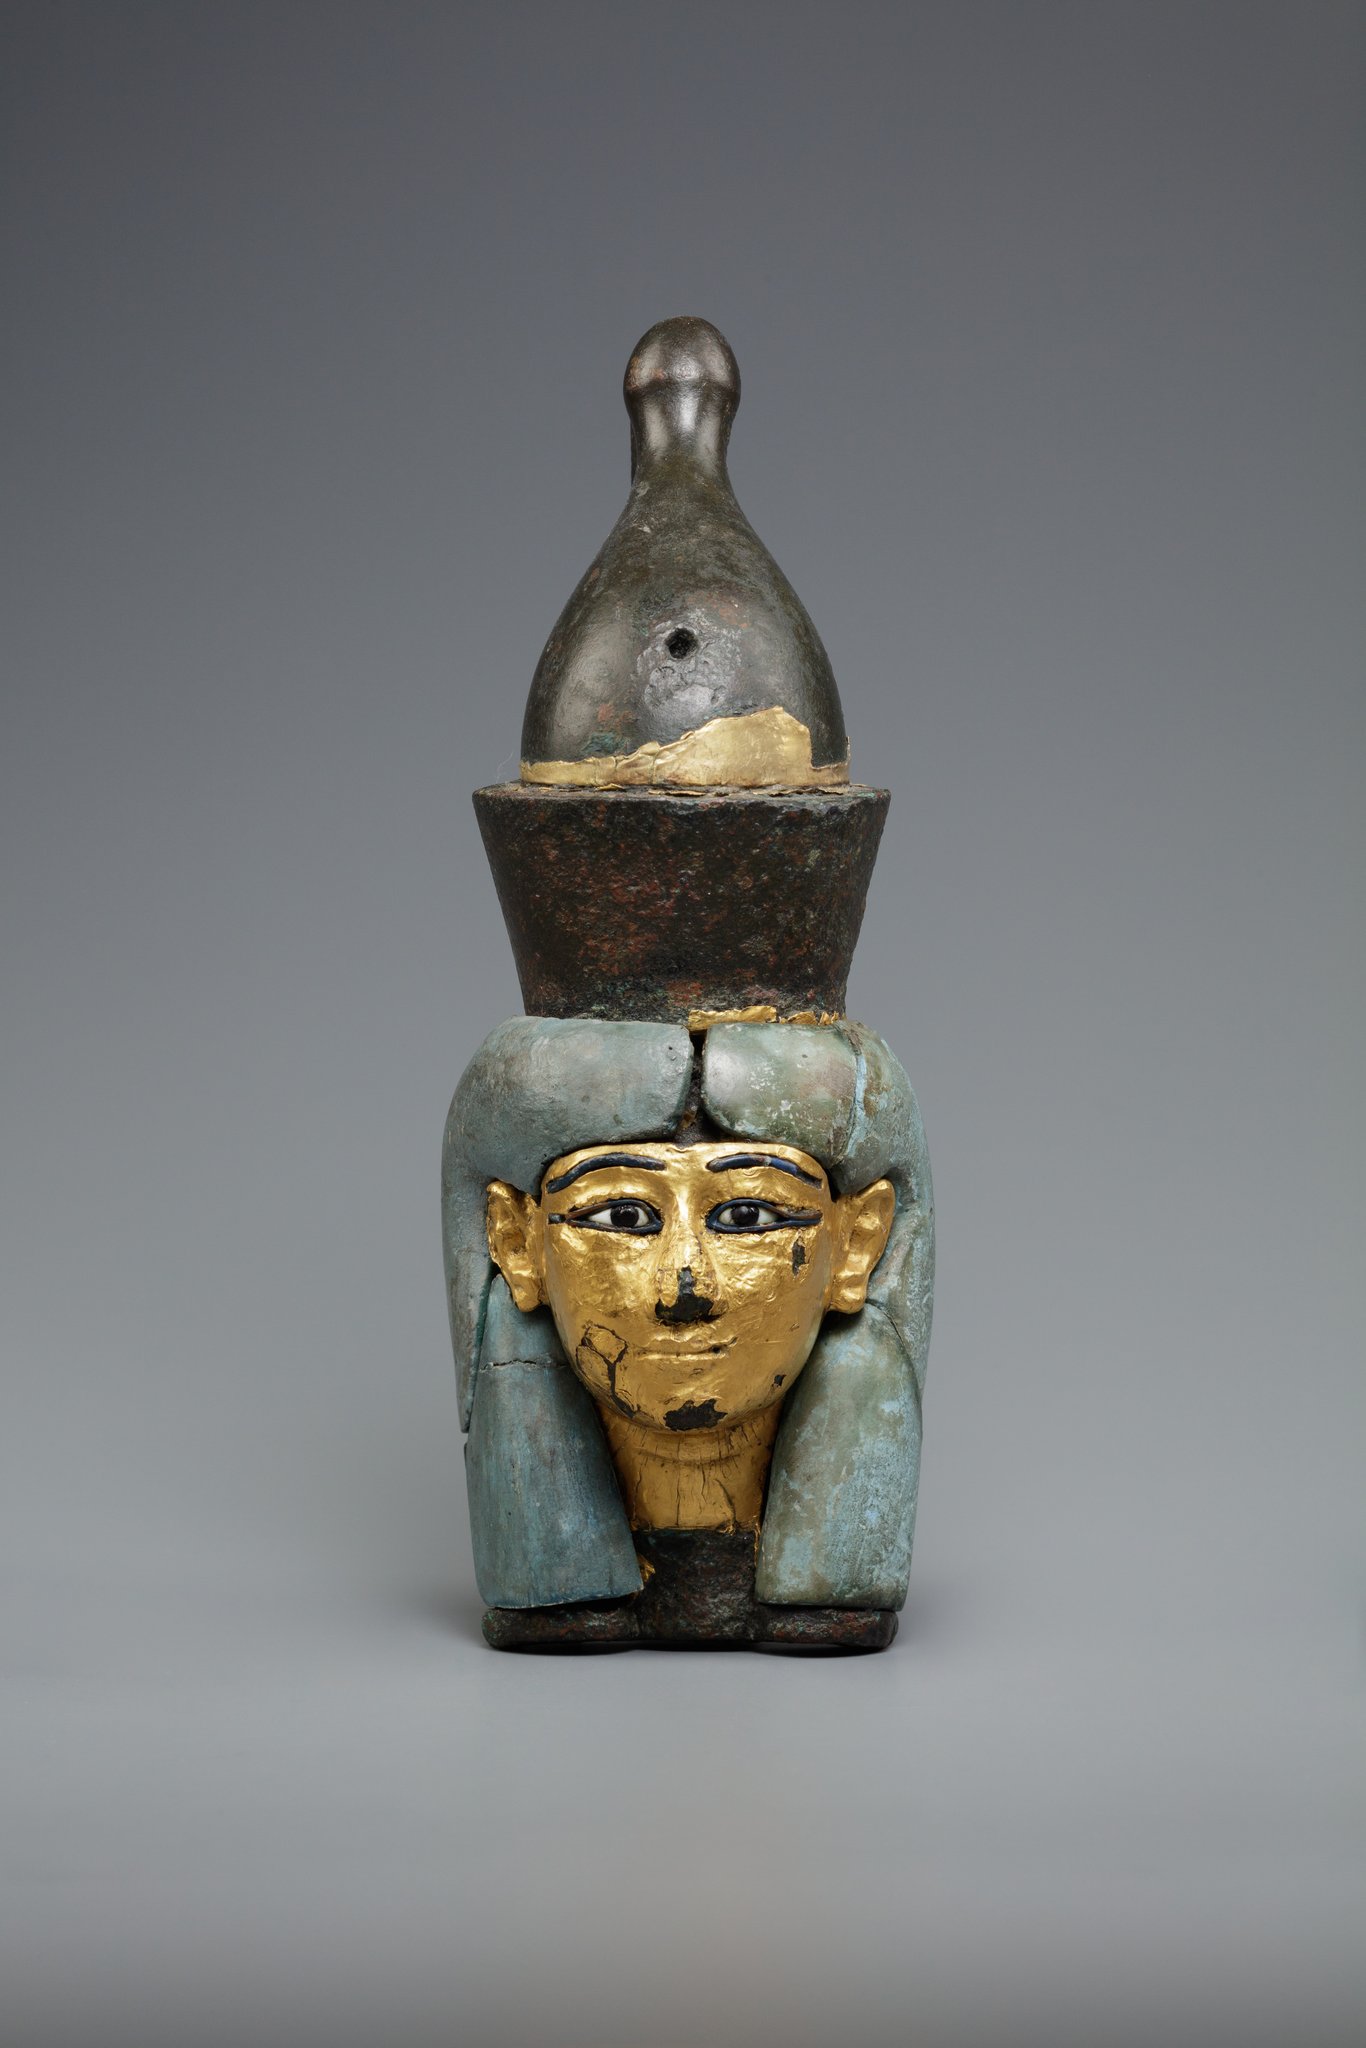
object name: statuette attachment, head of a goddess, double crown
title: Attachment in the form of the head of a goddess wearing the double crown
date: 1070-664 BCE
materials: bronze, glass, gold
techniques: inlay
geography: egypt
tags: goddess